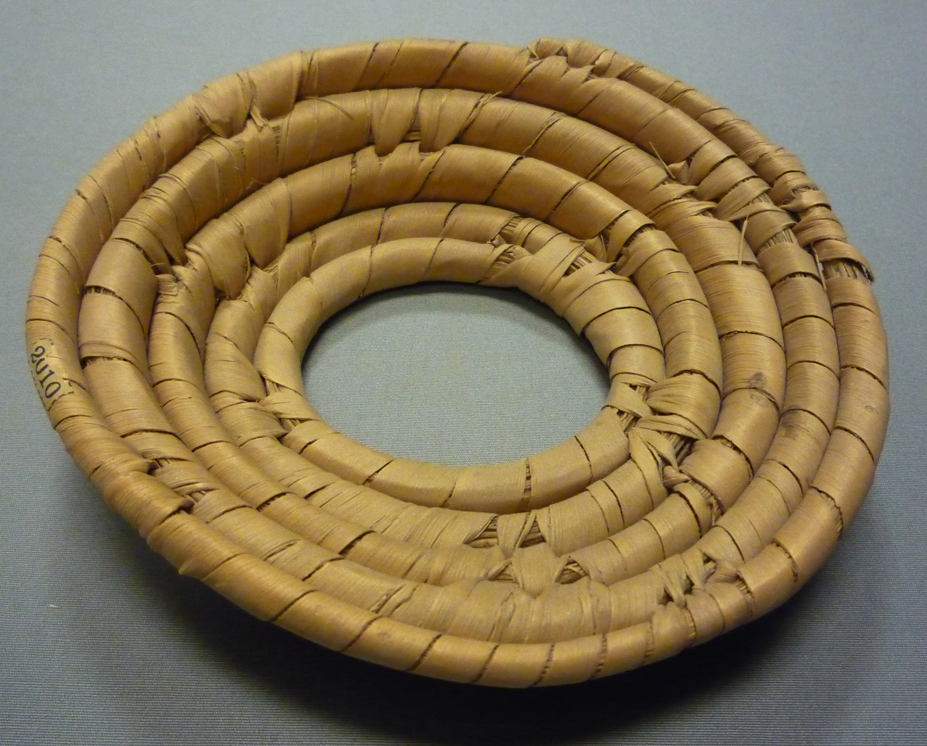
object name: pot stand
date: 1479-1458 BCE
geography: egypt